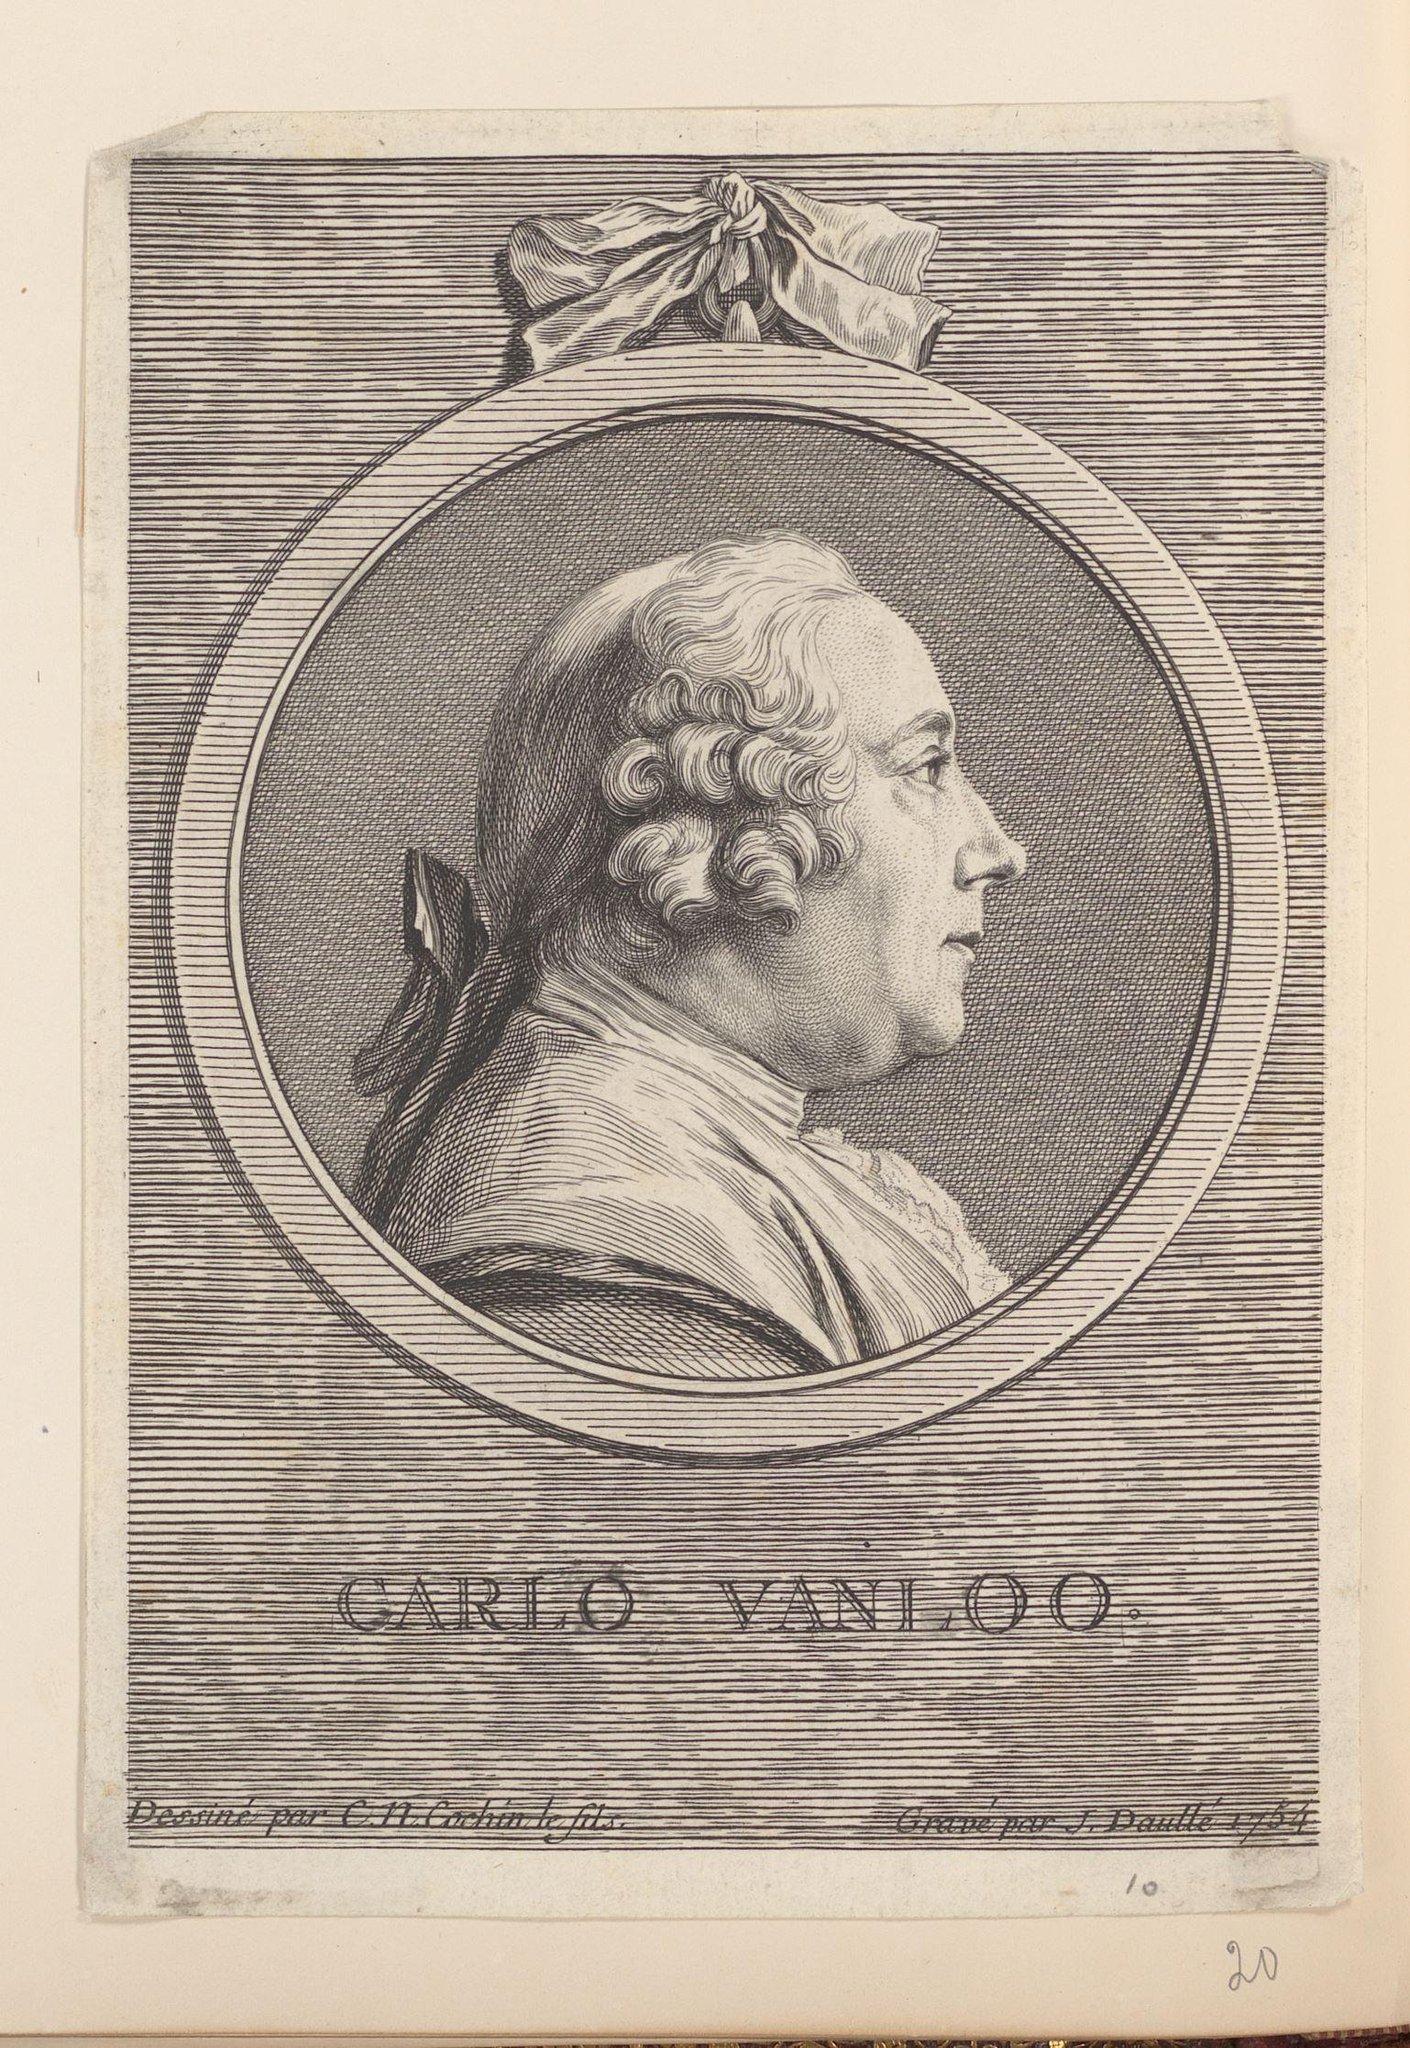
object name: print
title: Carlo Vanloo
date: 1754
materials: paper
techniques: engraving, etching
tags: paris, painter, print maker, carle van loo, historical persons, portrait, self-portrait of painter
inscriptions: date